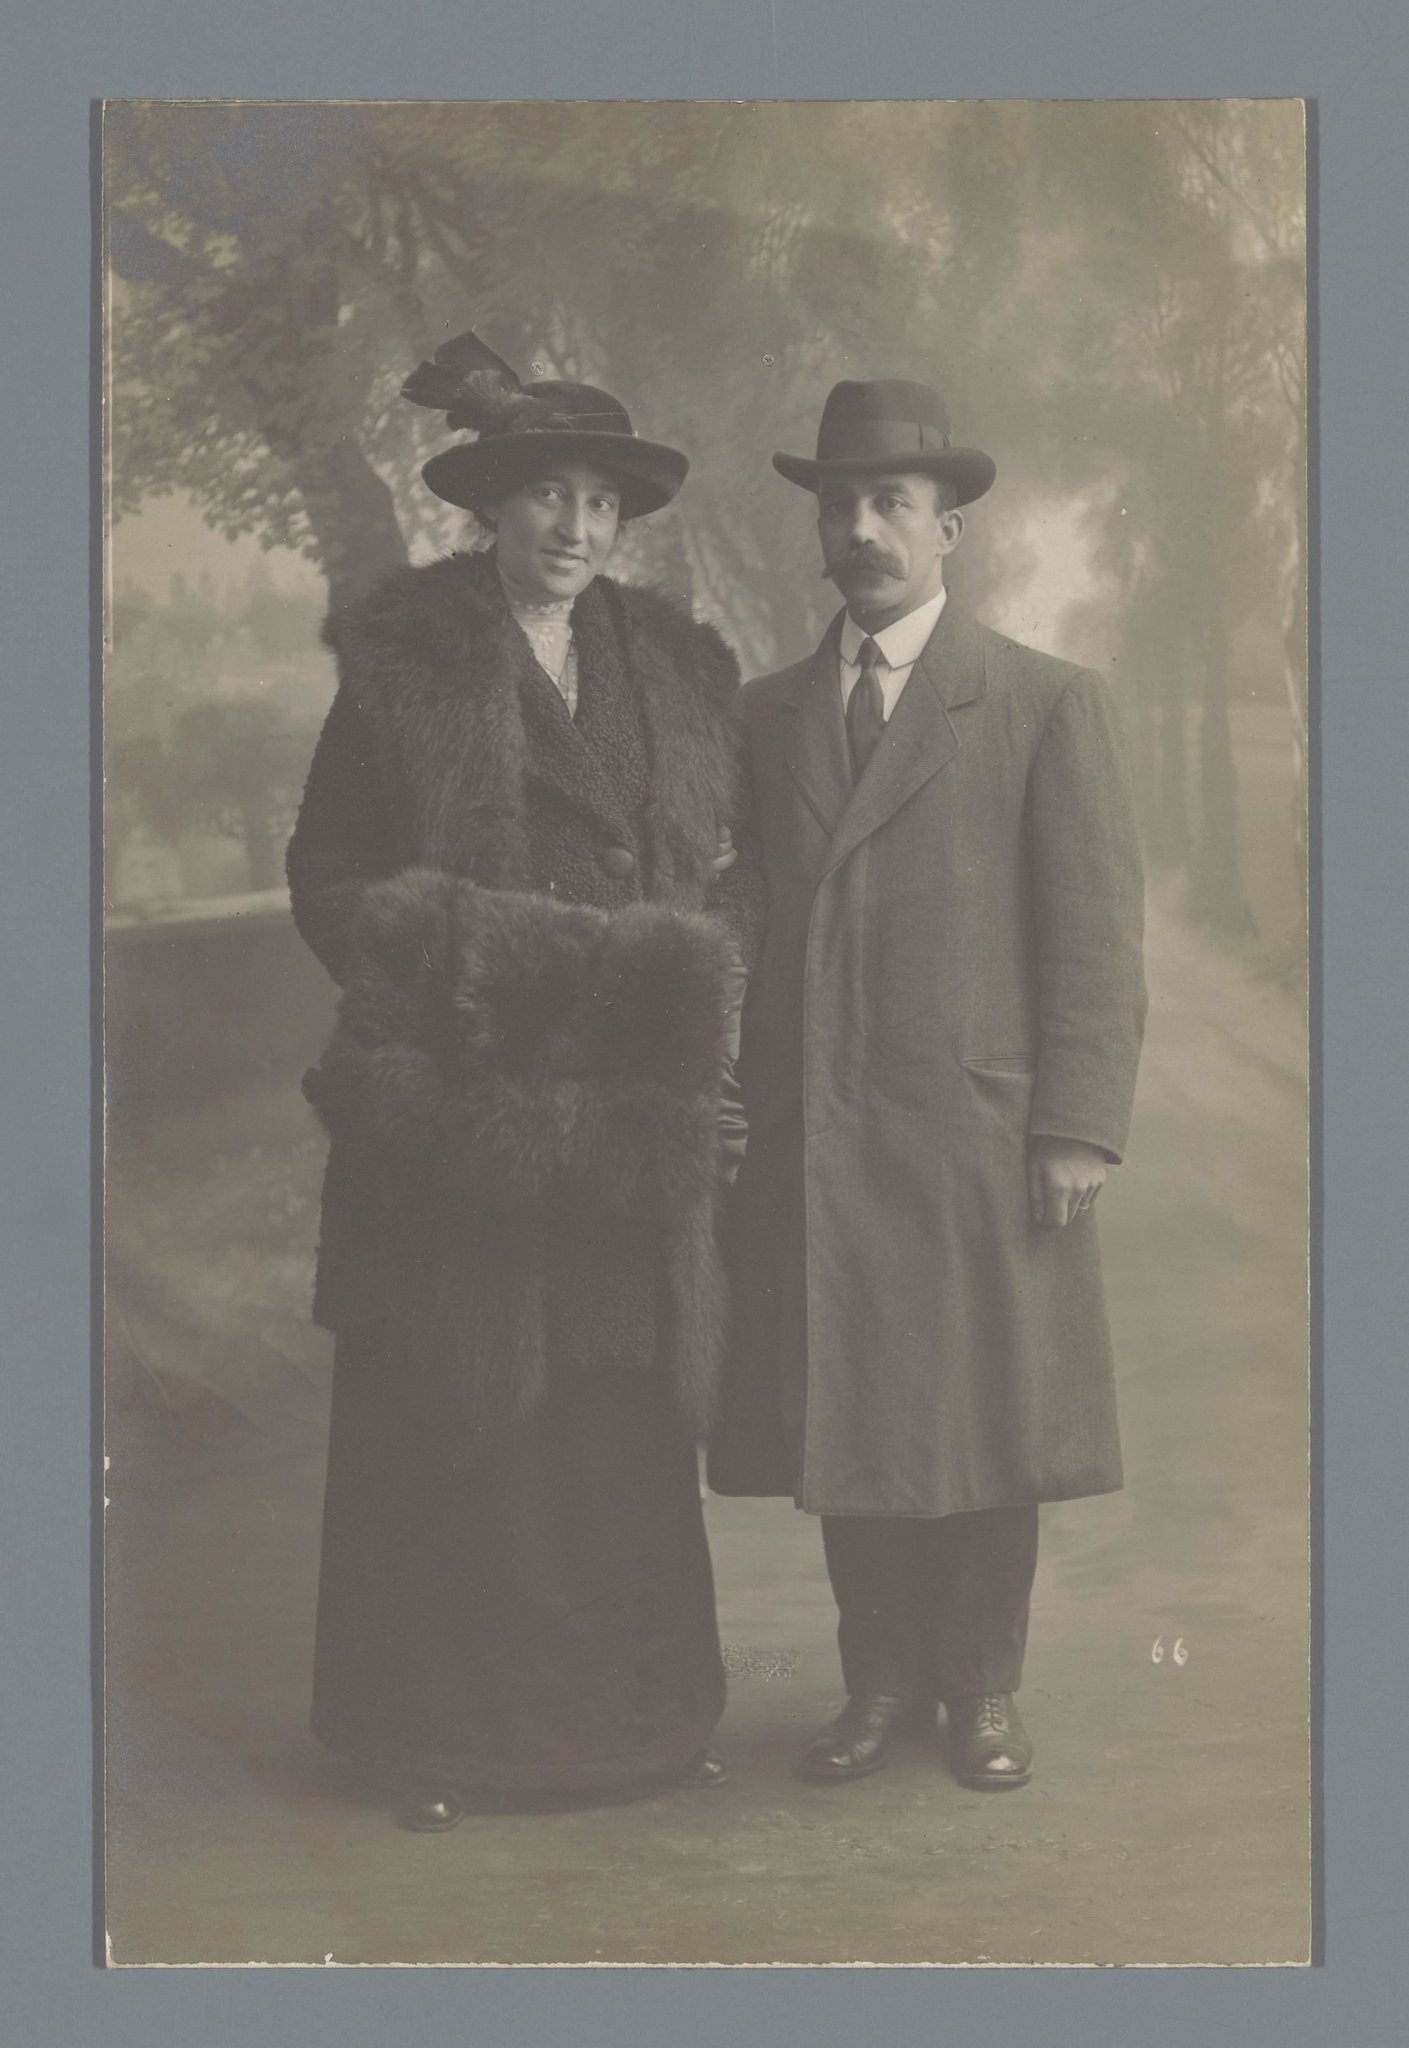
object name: ansichtkaart, prentbriefkaart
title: Studioportret van een onbekende man en vrouw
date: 1907-1920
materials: photographic support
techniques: gelatin silver print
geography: amsterdam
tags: studio ~ photographer, adult woman, adult man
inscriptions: inscription: ‘Atelier Prinses, Kalverstraat 103. Amsterdam.’, number: ‘66’